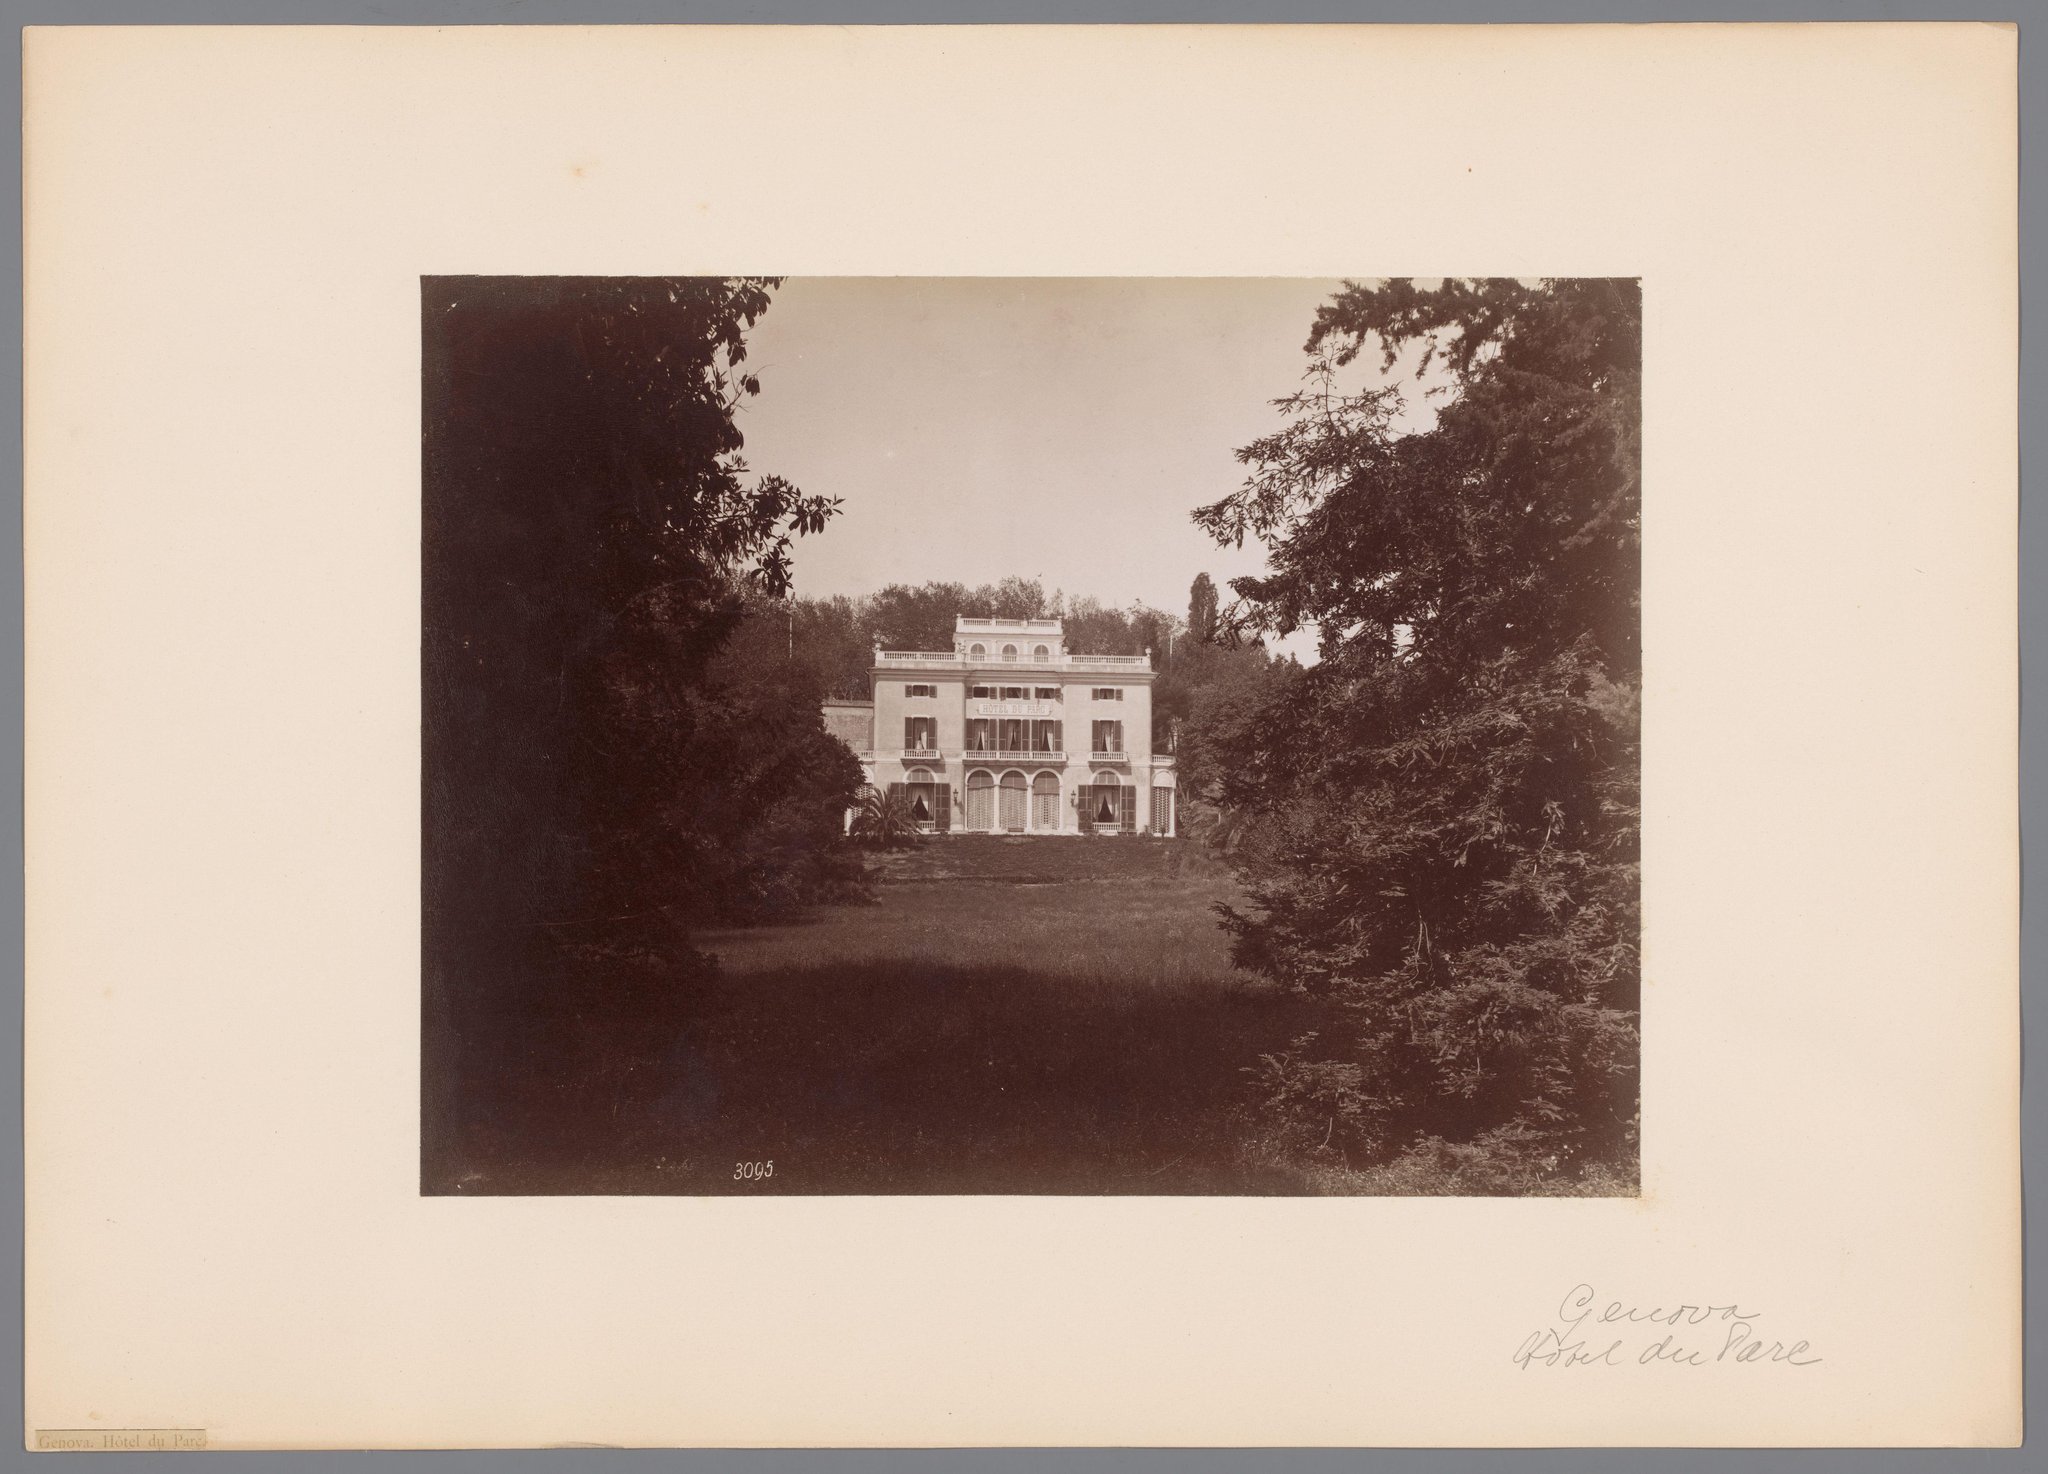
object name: photograph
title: Gezicht op Hotel du Parc te Genua, Italië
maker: alfredo noack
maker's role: fotograaf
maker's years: 1833-1895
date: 1858-1893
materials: cardboard, paper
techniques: albumen print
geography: genoa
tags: park, rural housing, e.g. country-house, villa, cottage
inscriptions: inscription: ‘Noack (t)’, number: ‘3095.’, inscription: ‘Genova/ Hotel du Parc’